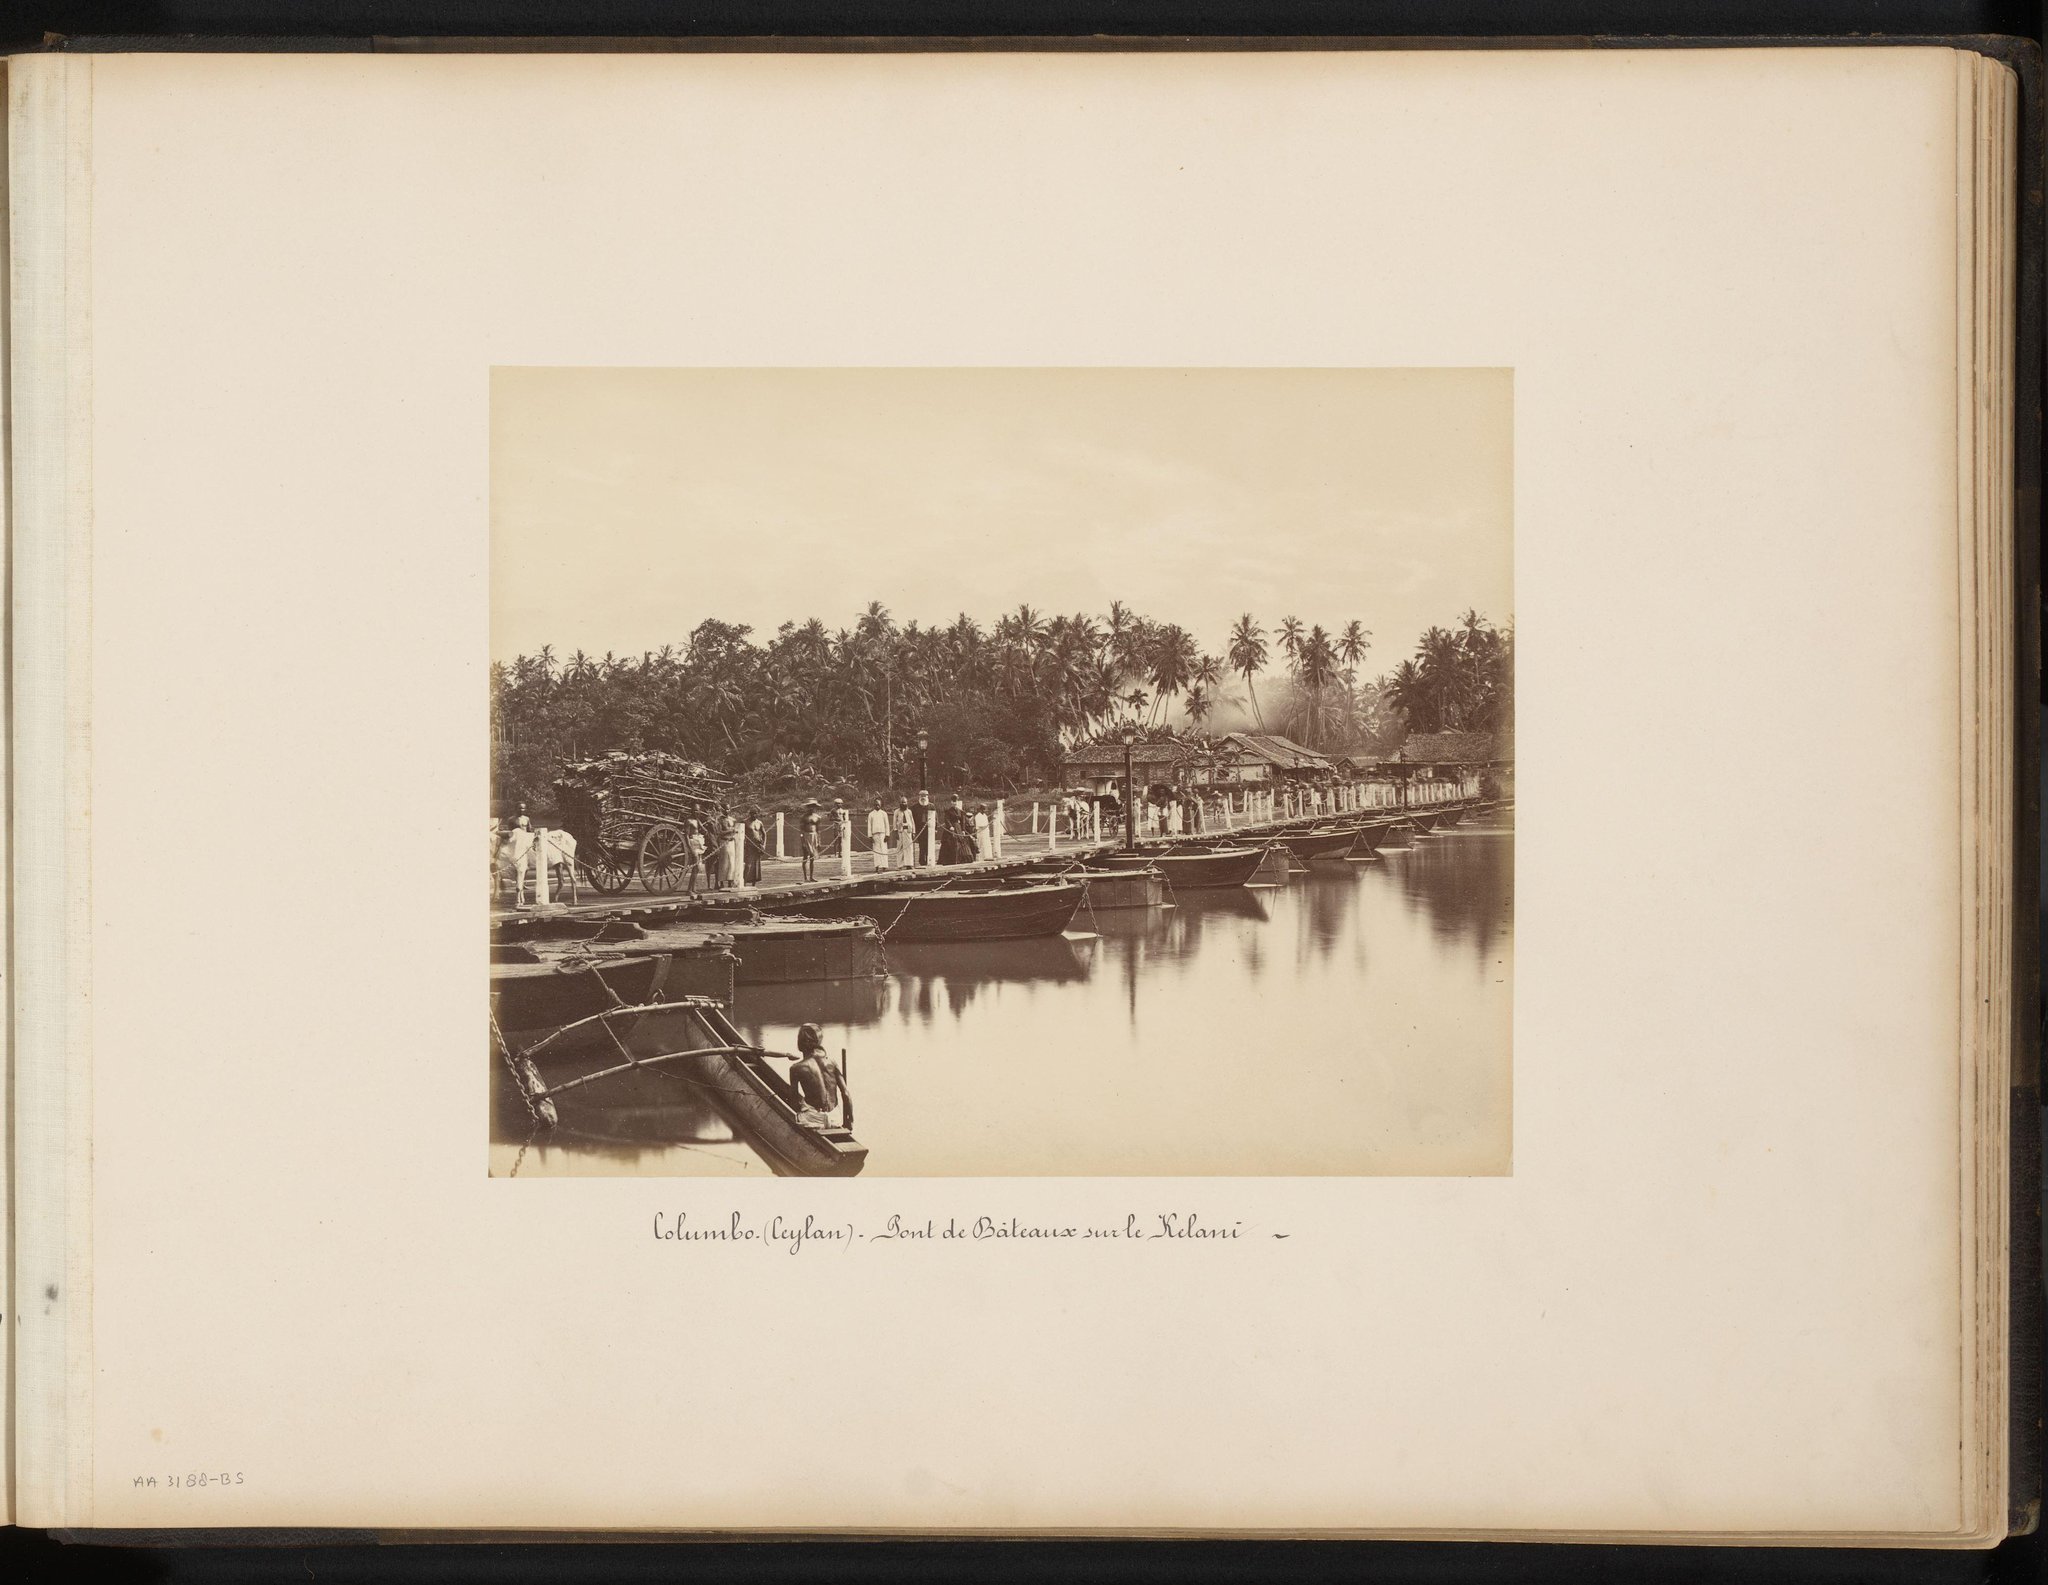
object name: photograph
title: Pontoon bridge on the Kelani river, Colombo, Sri Lanka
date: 1880-1883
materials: photographic support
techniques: albumen print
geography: colombo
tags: pontoon bridge, bridge in city across river, canal, etc.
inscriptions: inscription: ‘Photographers/ W.L.H. Skeen & Co./ Colombo. Ceylon’, title: ‘Columbo. (Ceylan) _ Pont de Bateaux sur le Kelani _’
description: Onderdeel van Reisalbum met opnames van bezienswaardigheden in Egypte, Nederlands-Indië, Singapore en Ceylon.